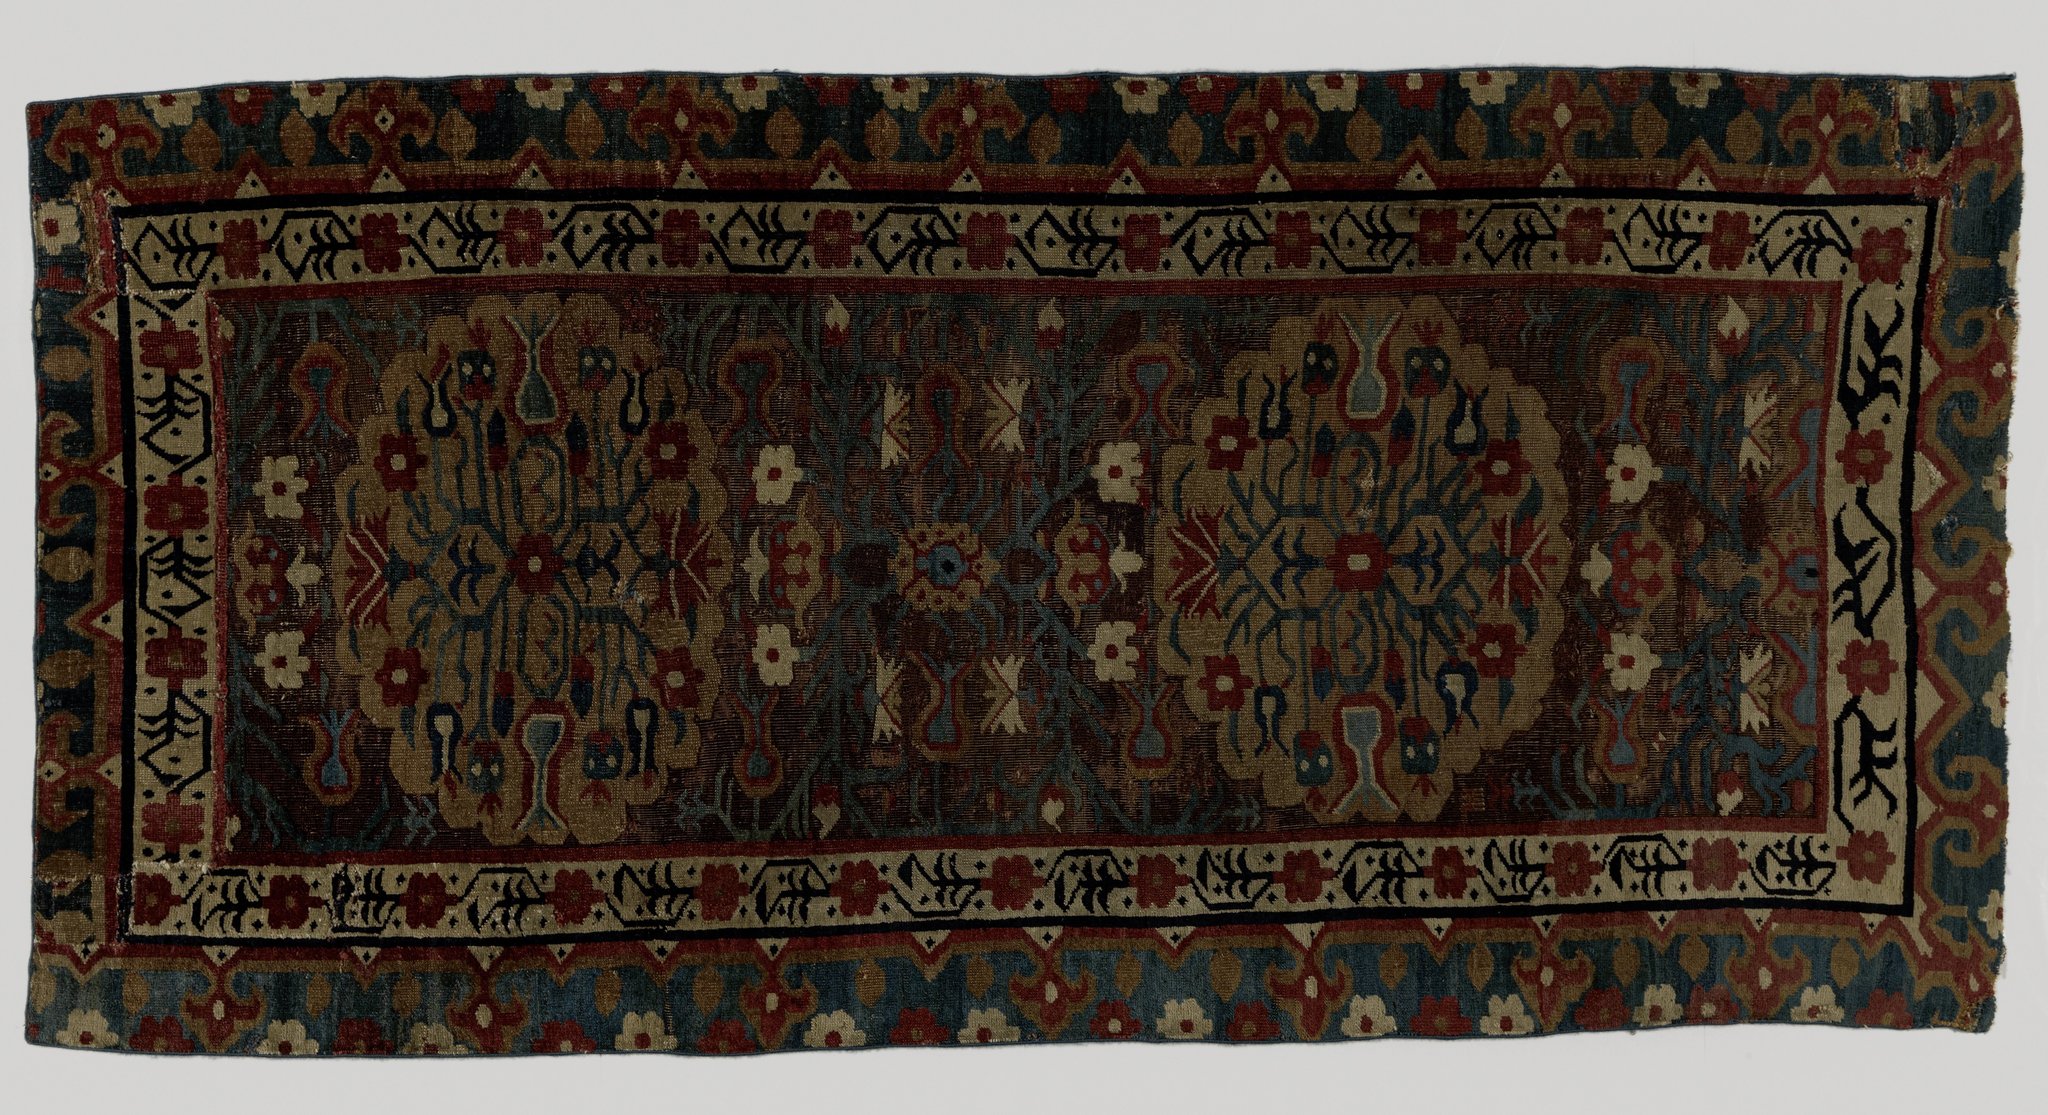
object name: oriental rug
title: Oosters tapijt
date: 1600-1650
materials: wool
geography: konya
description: Oosters tapijt, medaillonkleed. In het middenveld staan twee medaillons, ranken en bloemen. De binnenste rand is versierd met een gestileerde florale rank met rozetten. Oorspronkelijk was dit tapijt een loper, deze is echter door de vorige eigenaar ingekort.